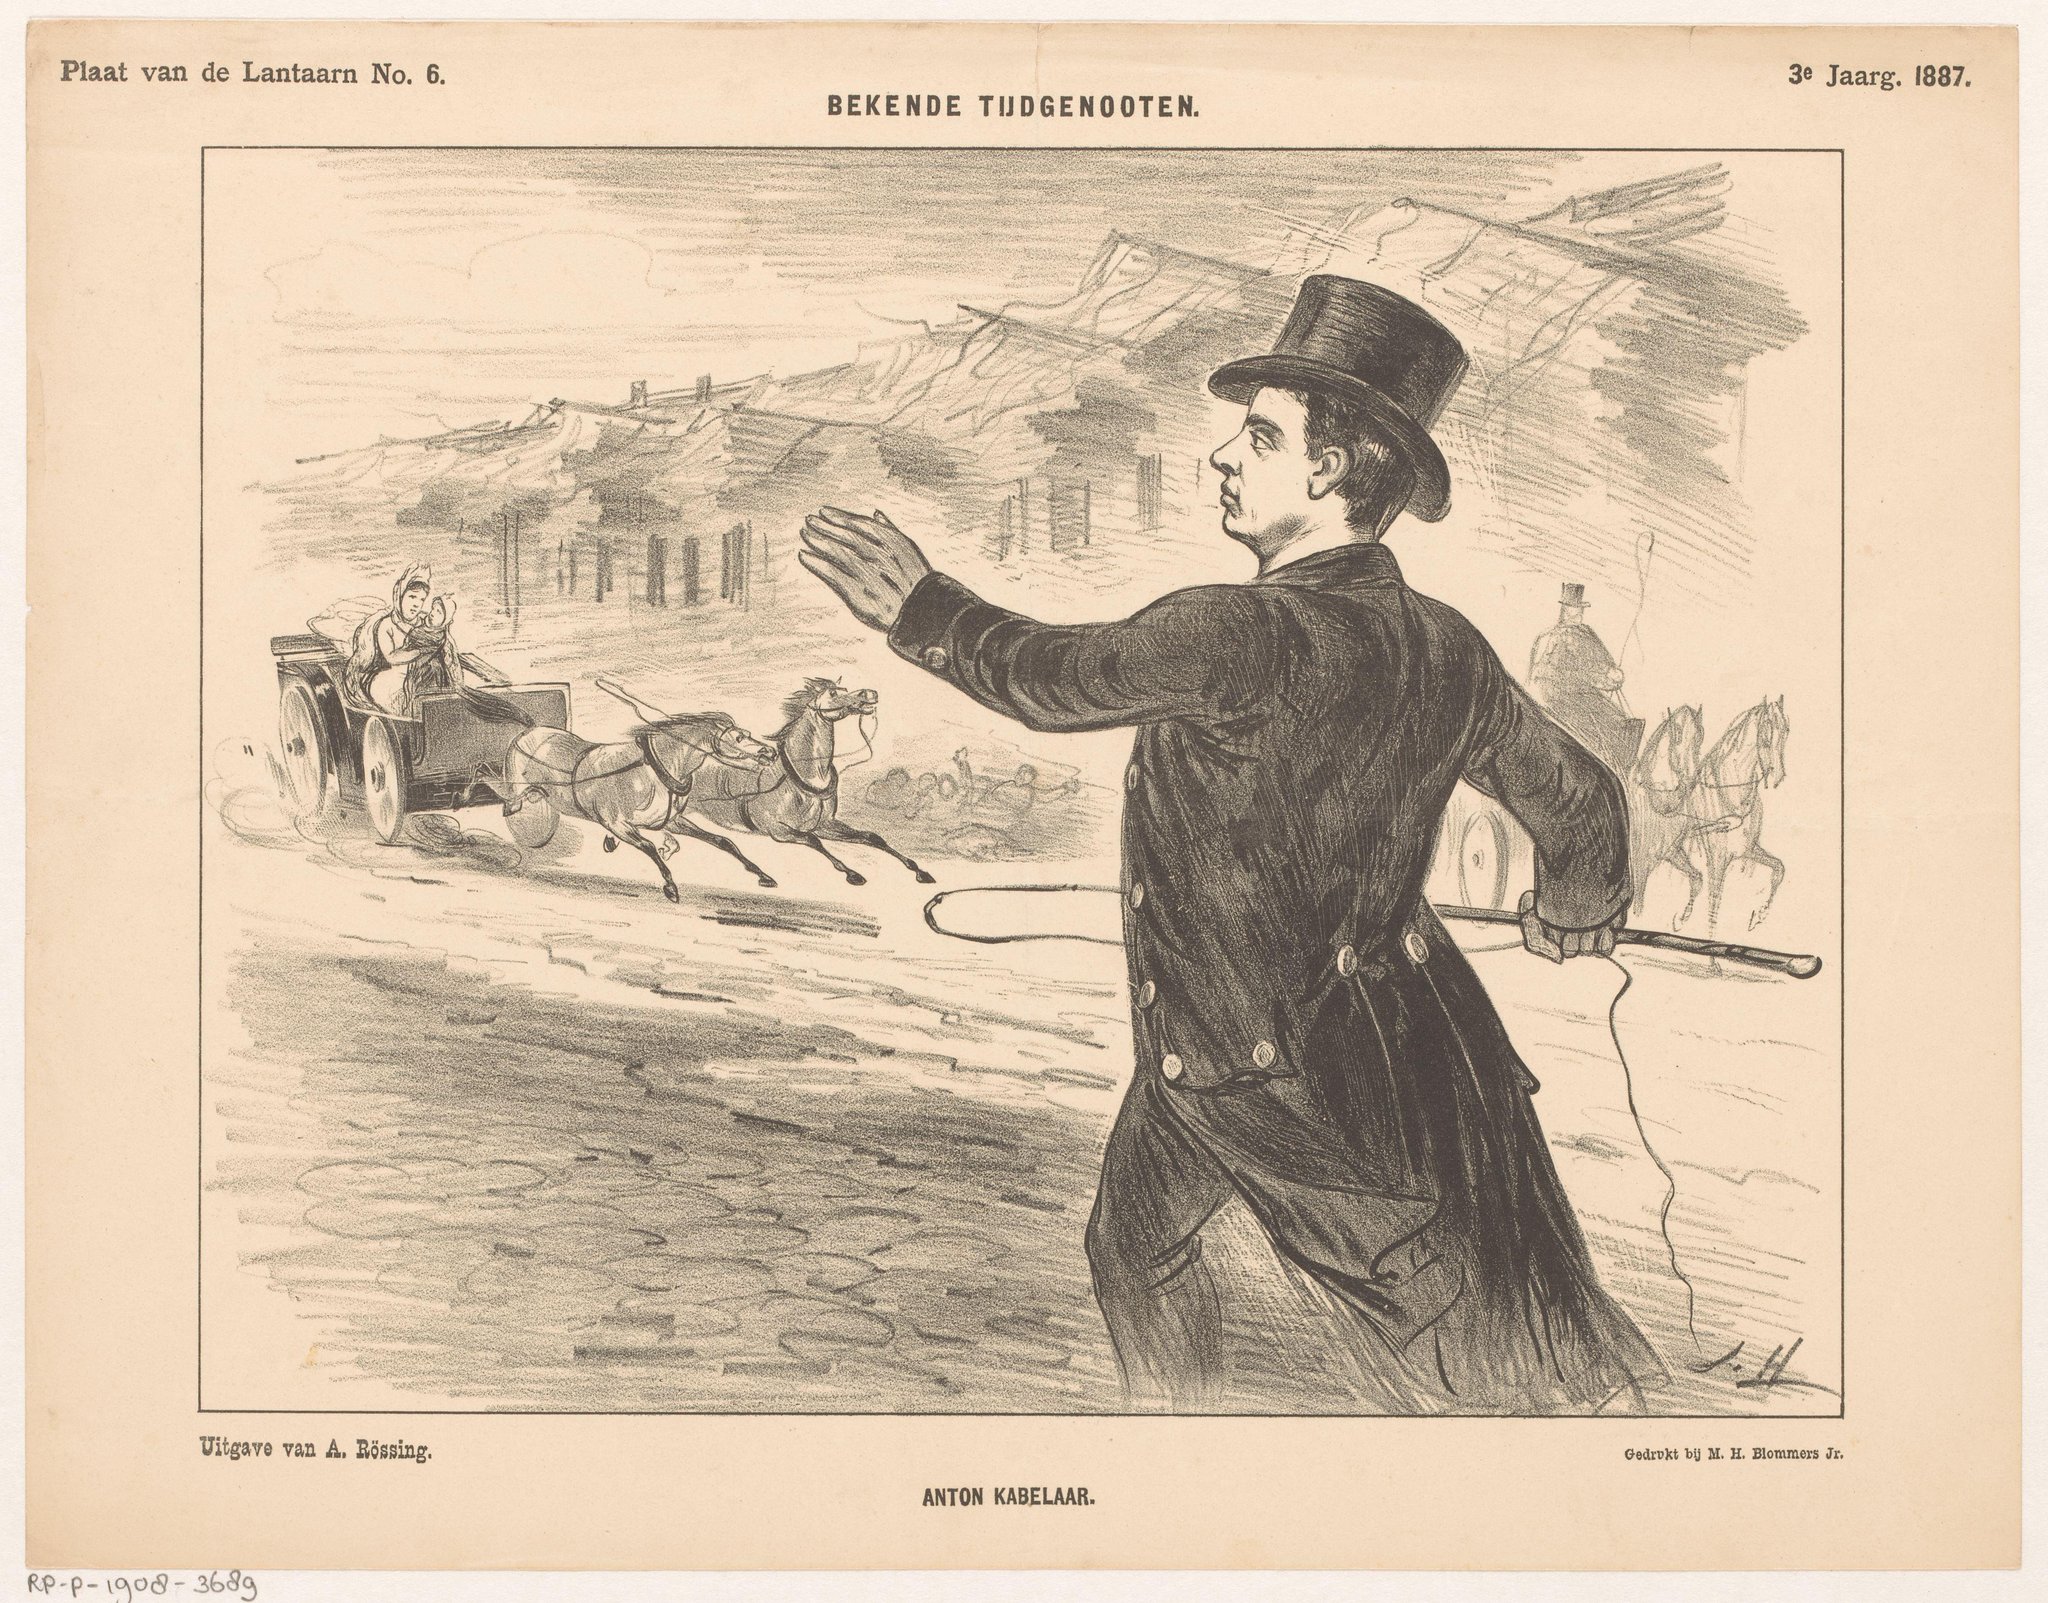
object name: cartoon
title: Bekende tijdgenooten: Anton Kabelaar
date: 1887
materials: paper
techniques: lithograph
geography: the hague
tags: the hague, print maker, wilhelmina of the netherlands, emma (queen consort of the netherlands), accident with four-wheeled, animal-drawn vehicle, e.g.: cab, carriage, coach, bolting, running away (~ horse), political caricatures and satires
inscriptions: collector's mark: Lugt 2228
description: Anton Kabelaar bracht in 1887 de op hol geslagen paarden van het rijtuig van Koningin Emma en prinses Wilhelmina tot stilstand. Deze prent werd uitgegeven bij De Lantaarn.